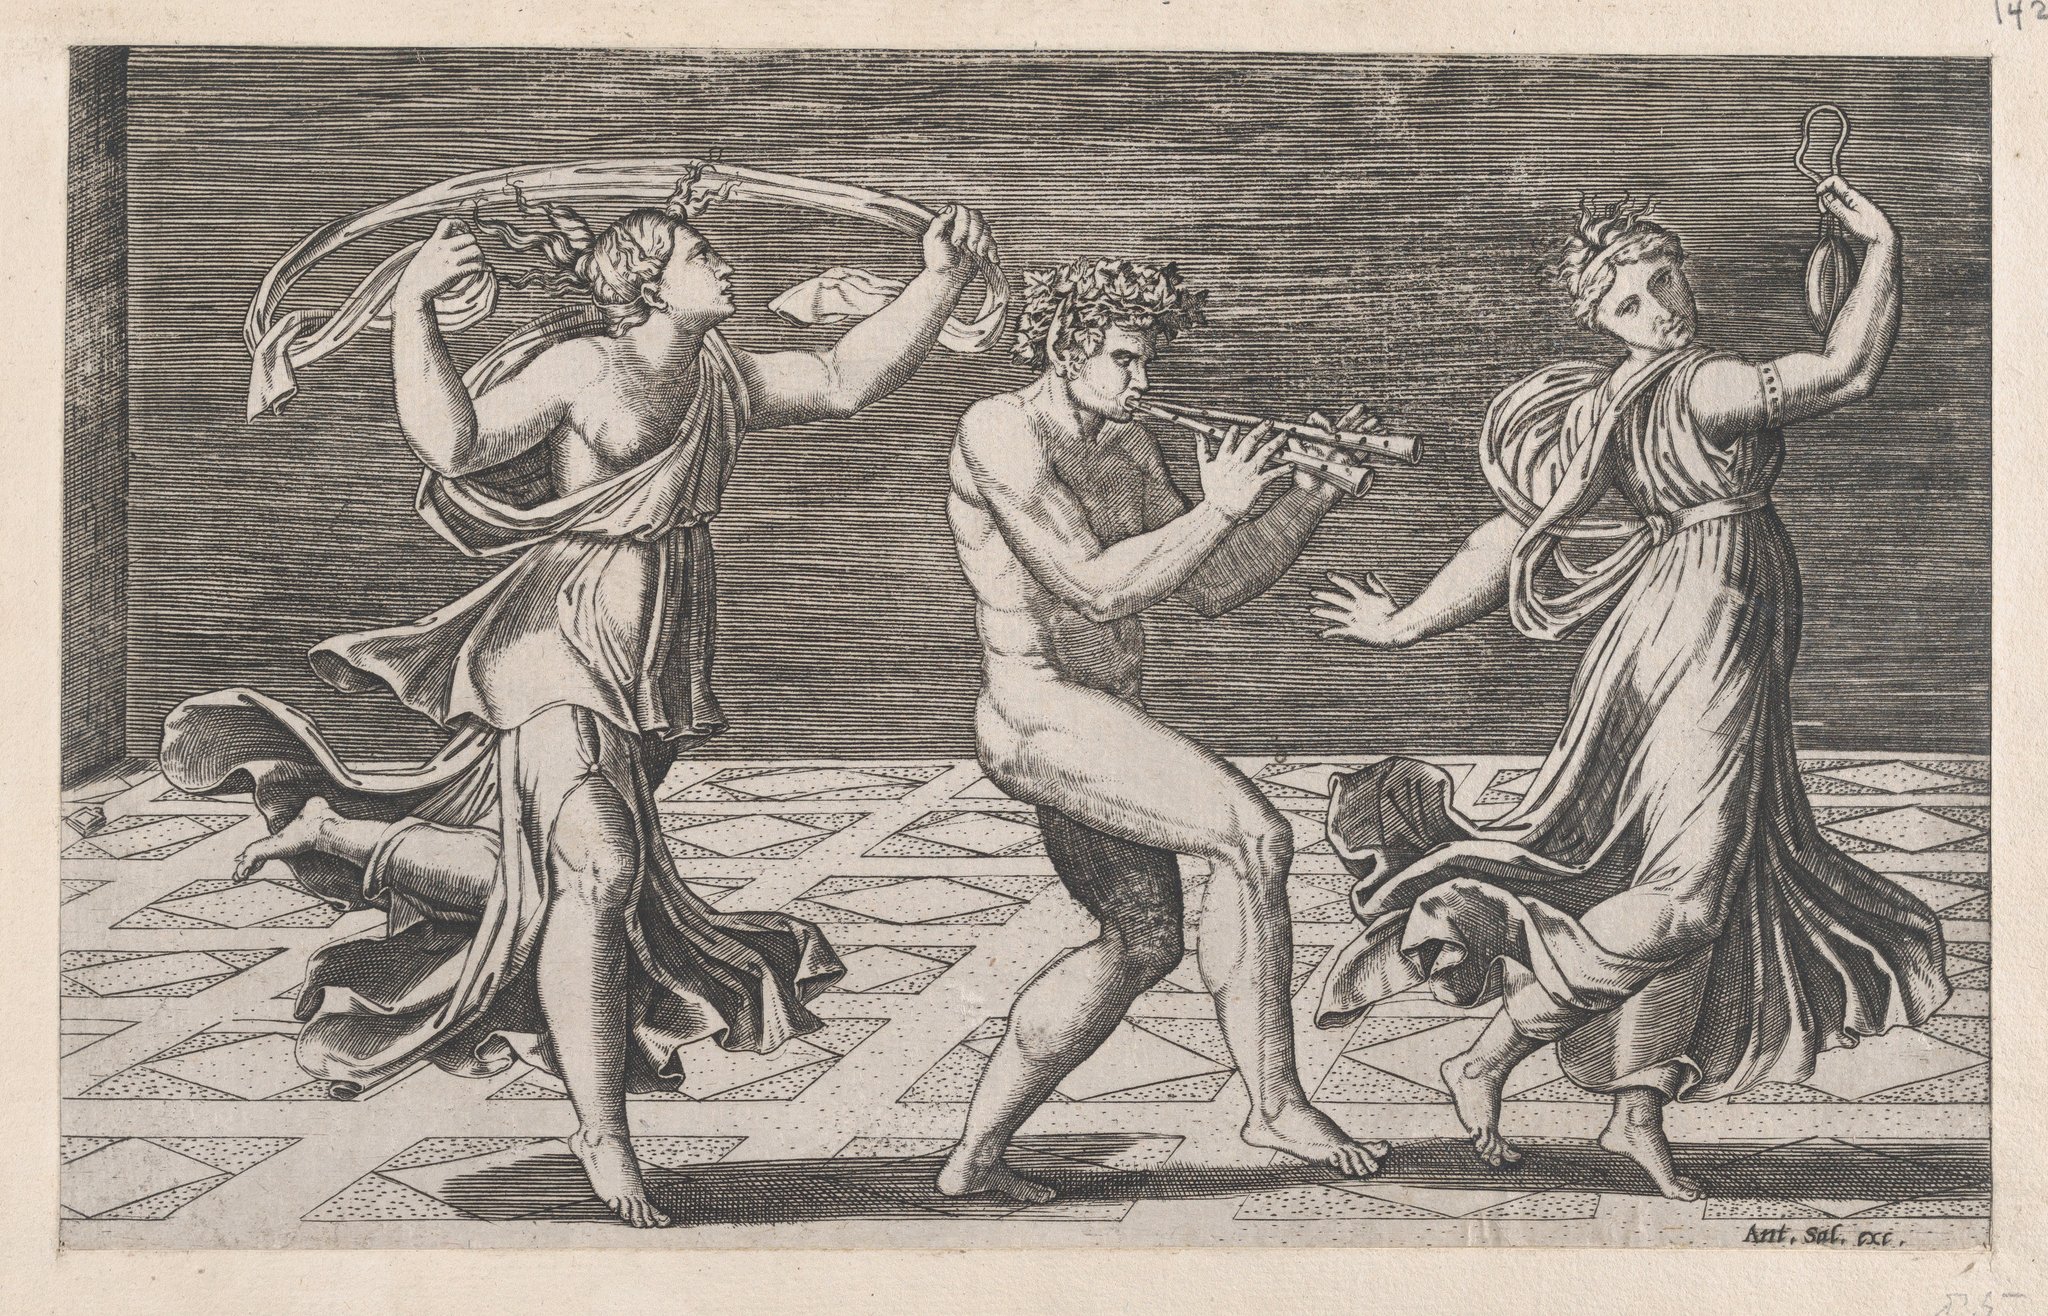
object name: print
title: Dance of Fauns and Bacchants, from "Speculum Romanae Magnificentiae"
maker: Anonymous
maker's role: artist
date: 1501-1533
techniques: engraving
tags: dancing,flutes,bacchantes,fauns